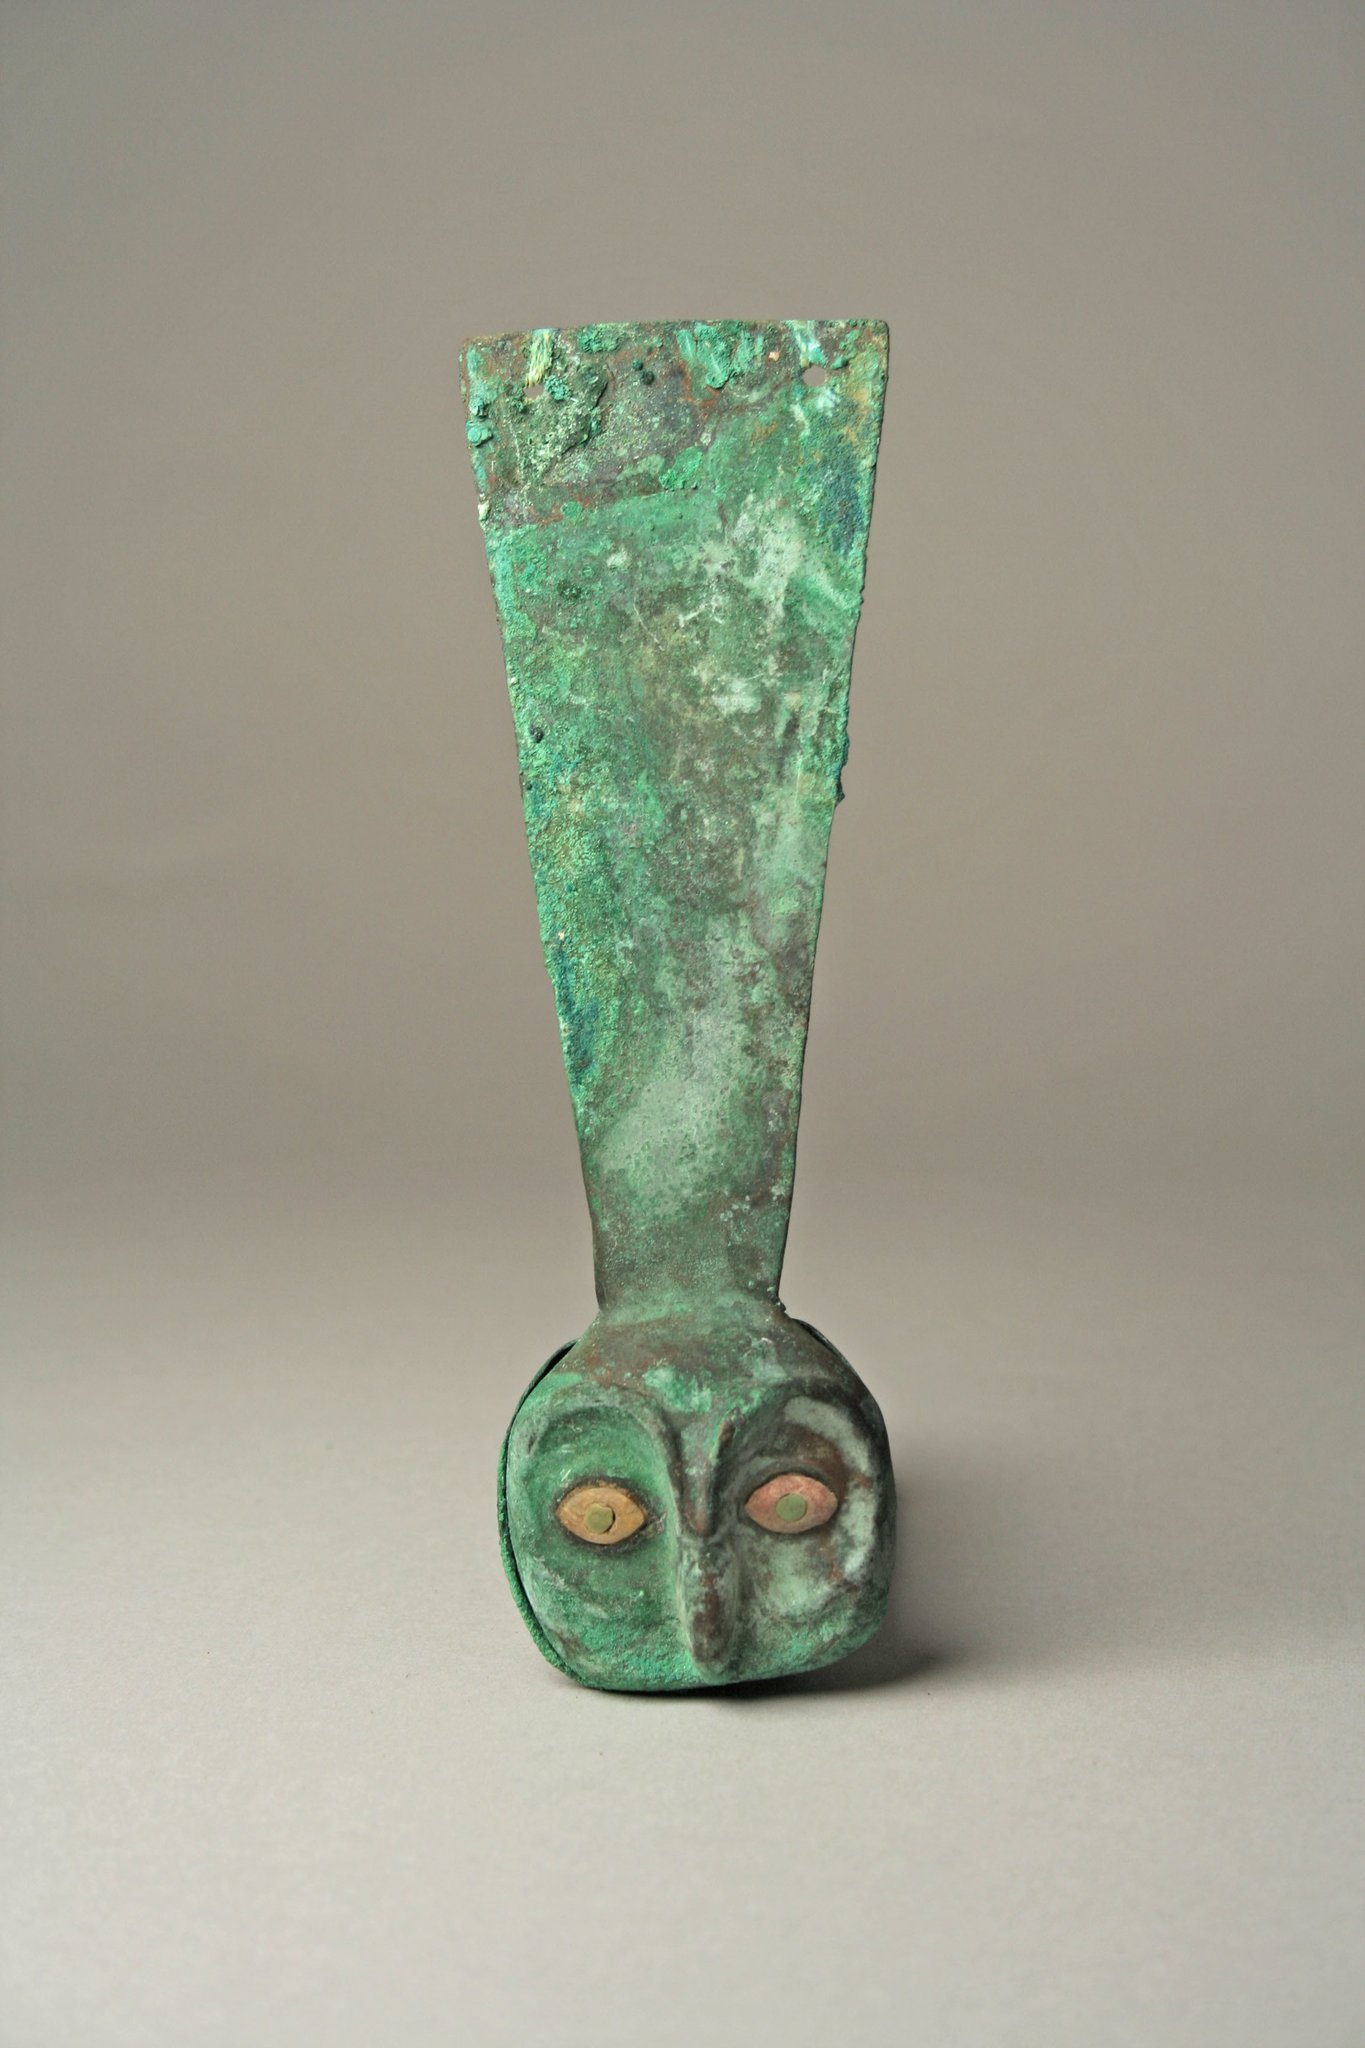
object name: ornament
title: Owl Tab Ornament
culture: moche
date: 501-700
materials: shell, metal, stone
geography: peru